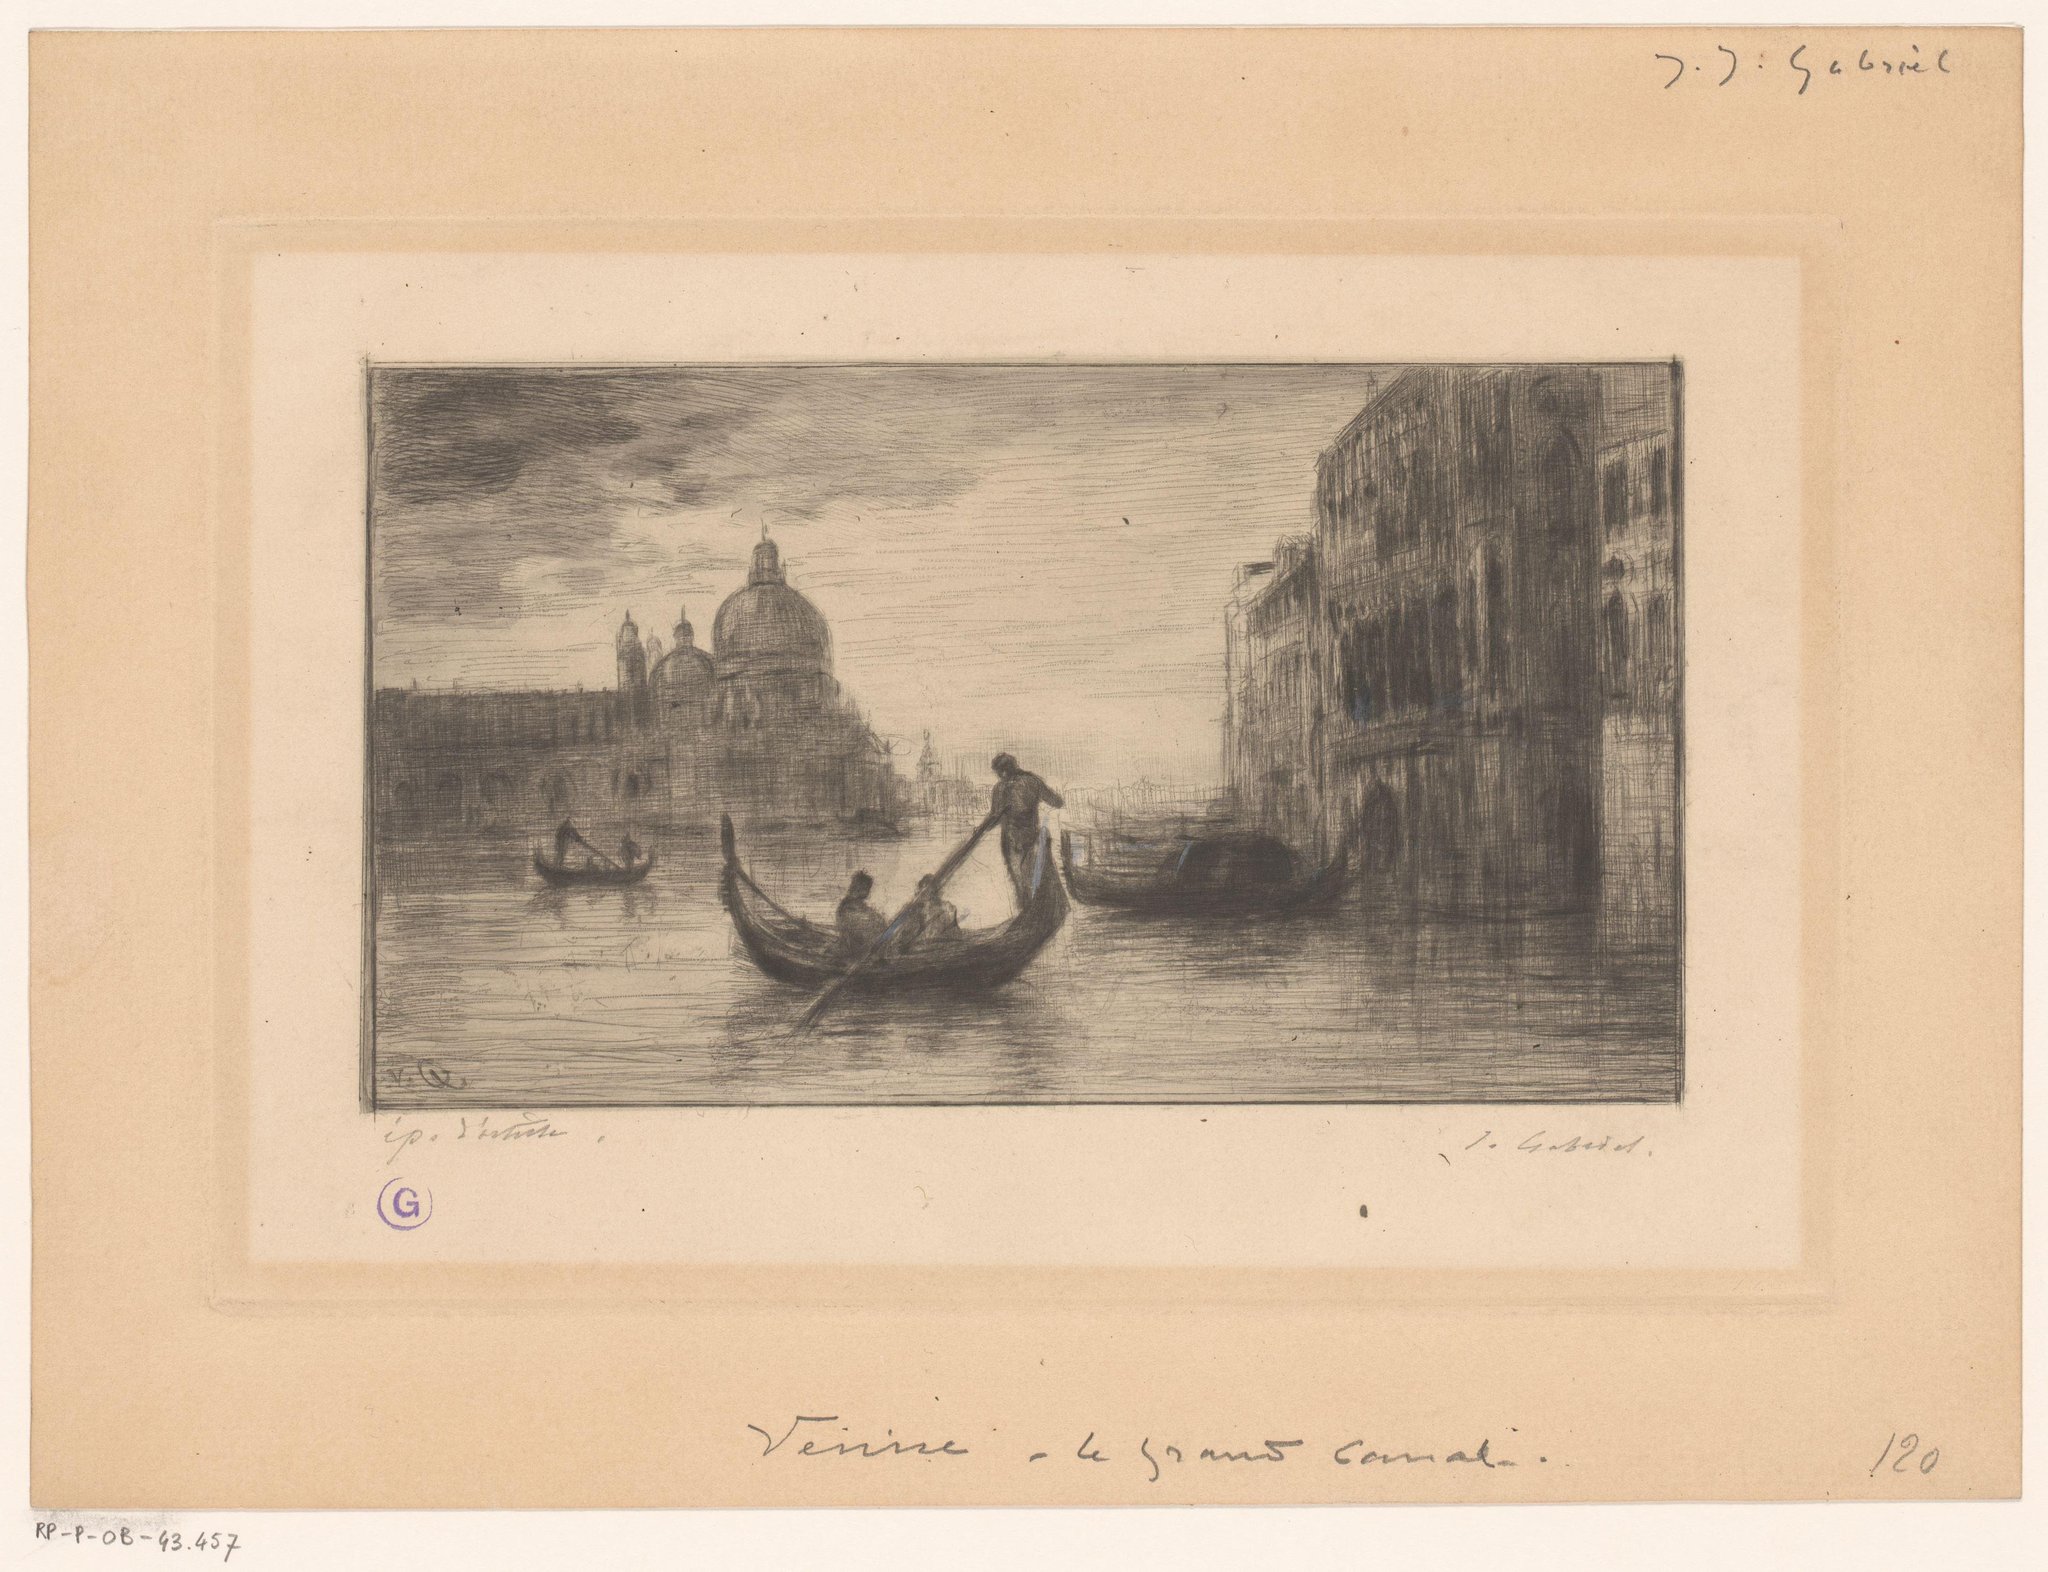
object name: print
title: Gezicht op de Canal Grande in Venetië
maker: justin gabriel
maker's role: print maker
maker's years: 1838-1923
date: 1848-1923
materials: paper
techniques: drypoint, roulette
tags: city-view in general; 'veduta', canal, gondola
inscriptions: stamp: ‘Letter 'G' in een cirkel.’ Lugt 1129b, collector's mark: Lugt 2228